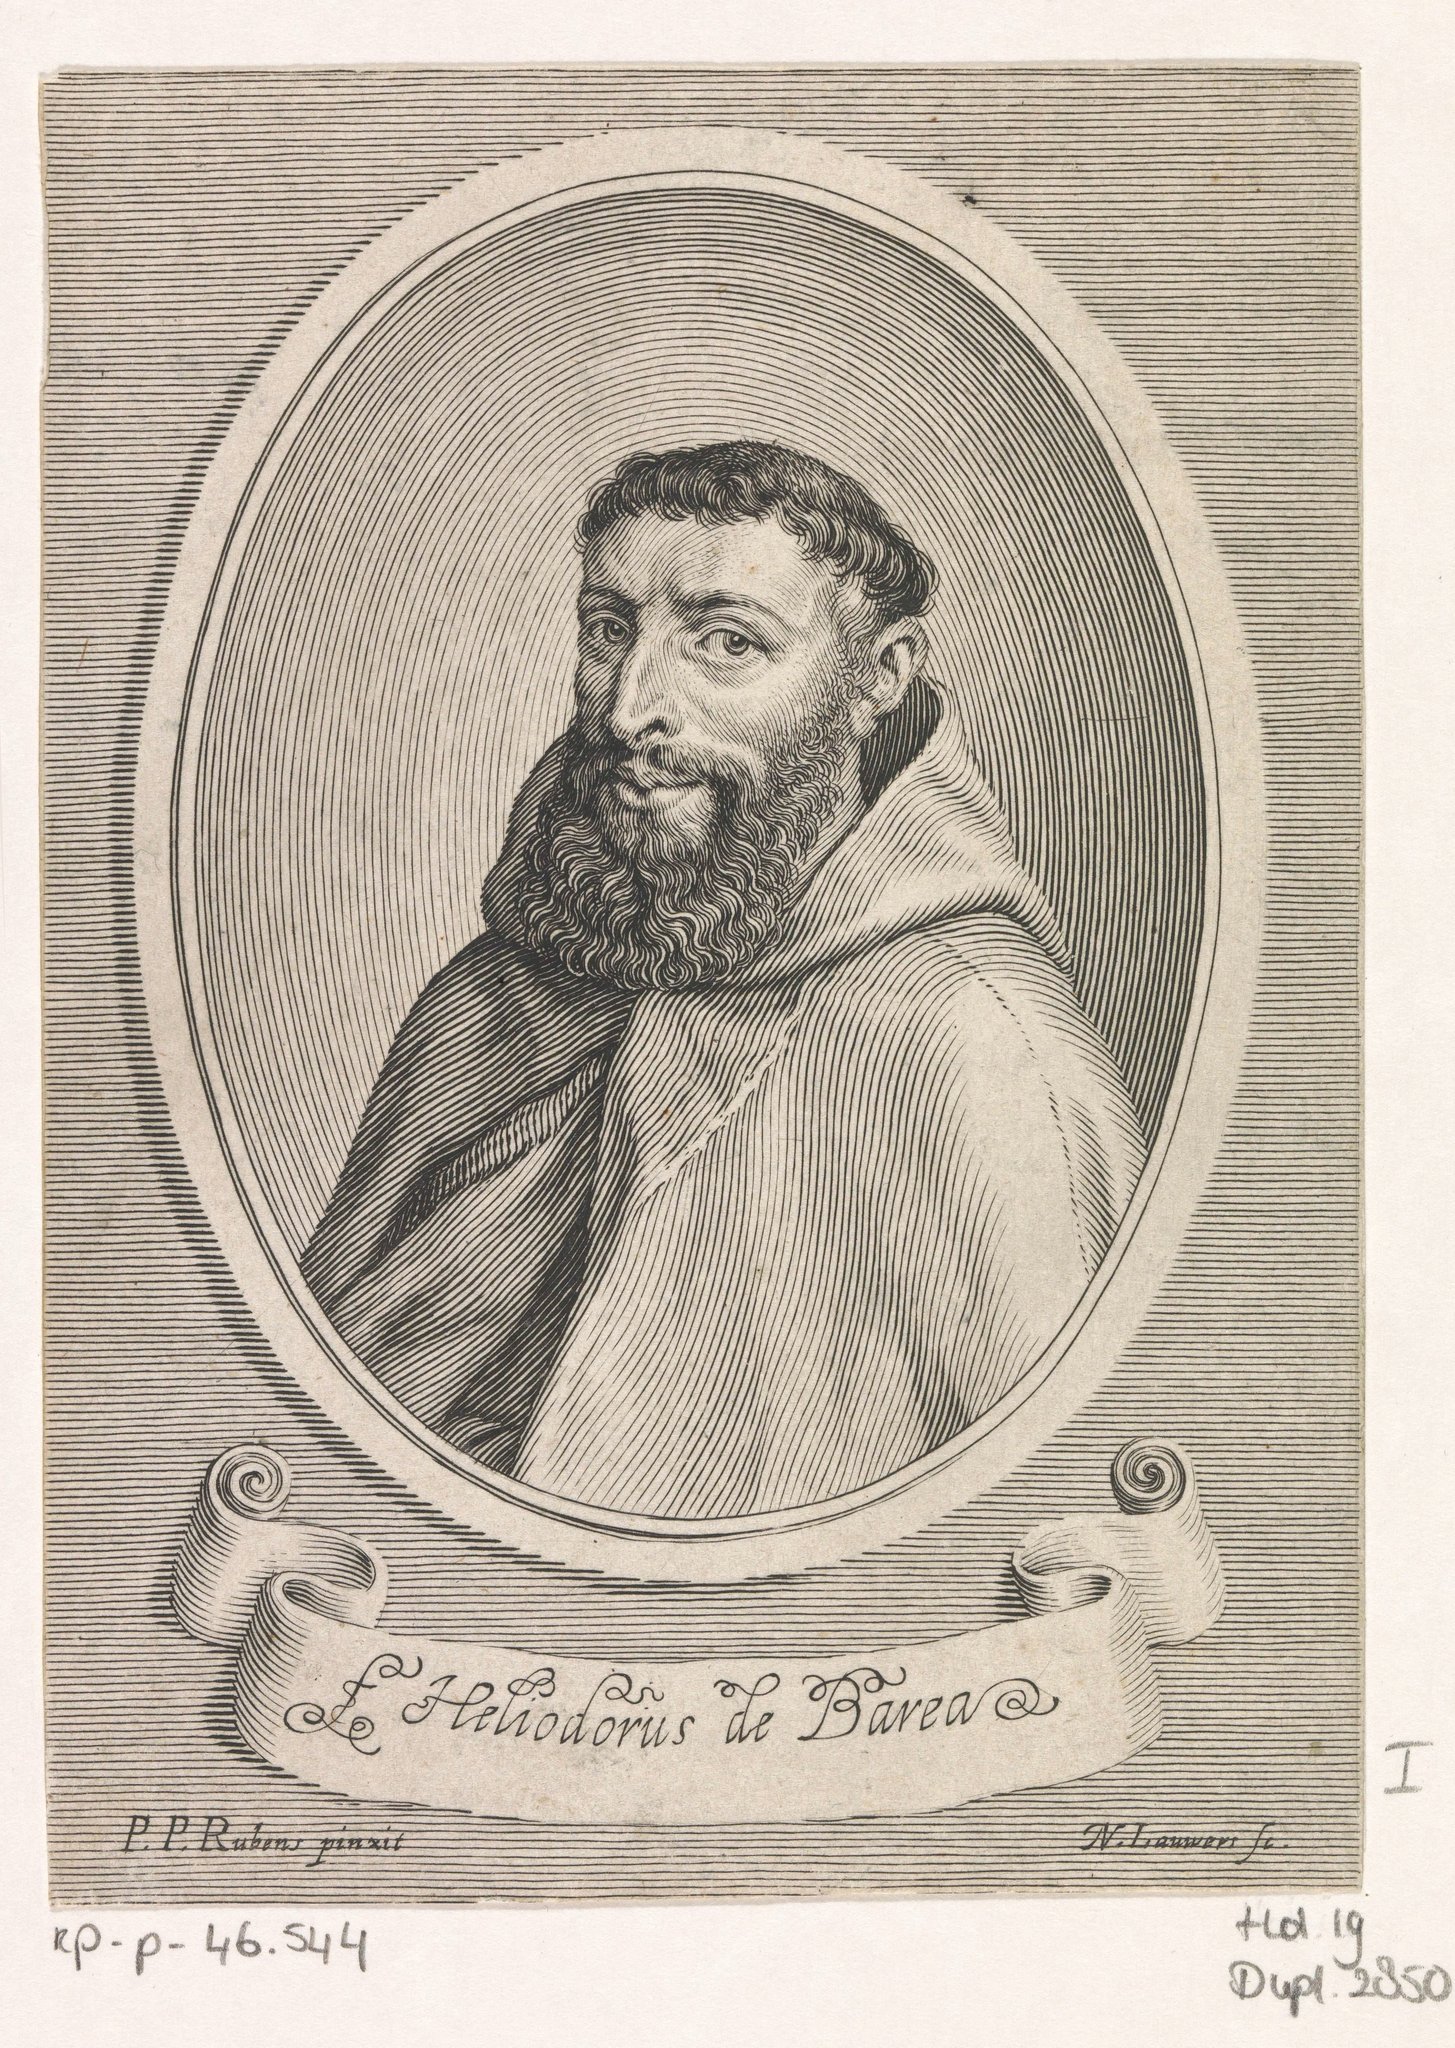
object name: print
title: Portret van Heliodor de Barea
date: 1619-1652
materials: paper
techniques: engraving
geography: antwerp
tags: minderbroeder, heliodor de barea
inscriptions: collector's mark: Lugt 240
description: Portretbuste in ovaal van de Spaanse martelaar Heliodor de Barea, gehuld in een habijt. Op een banderol onder het ovaal staat de naam van de geportretteerde.